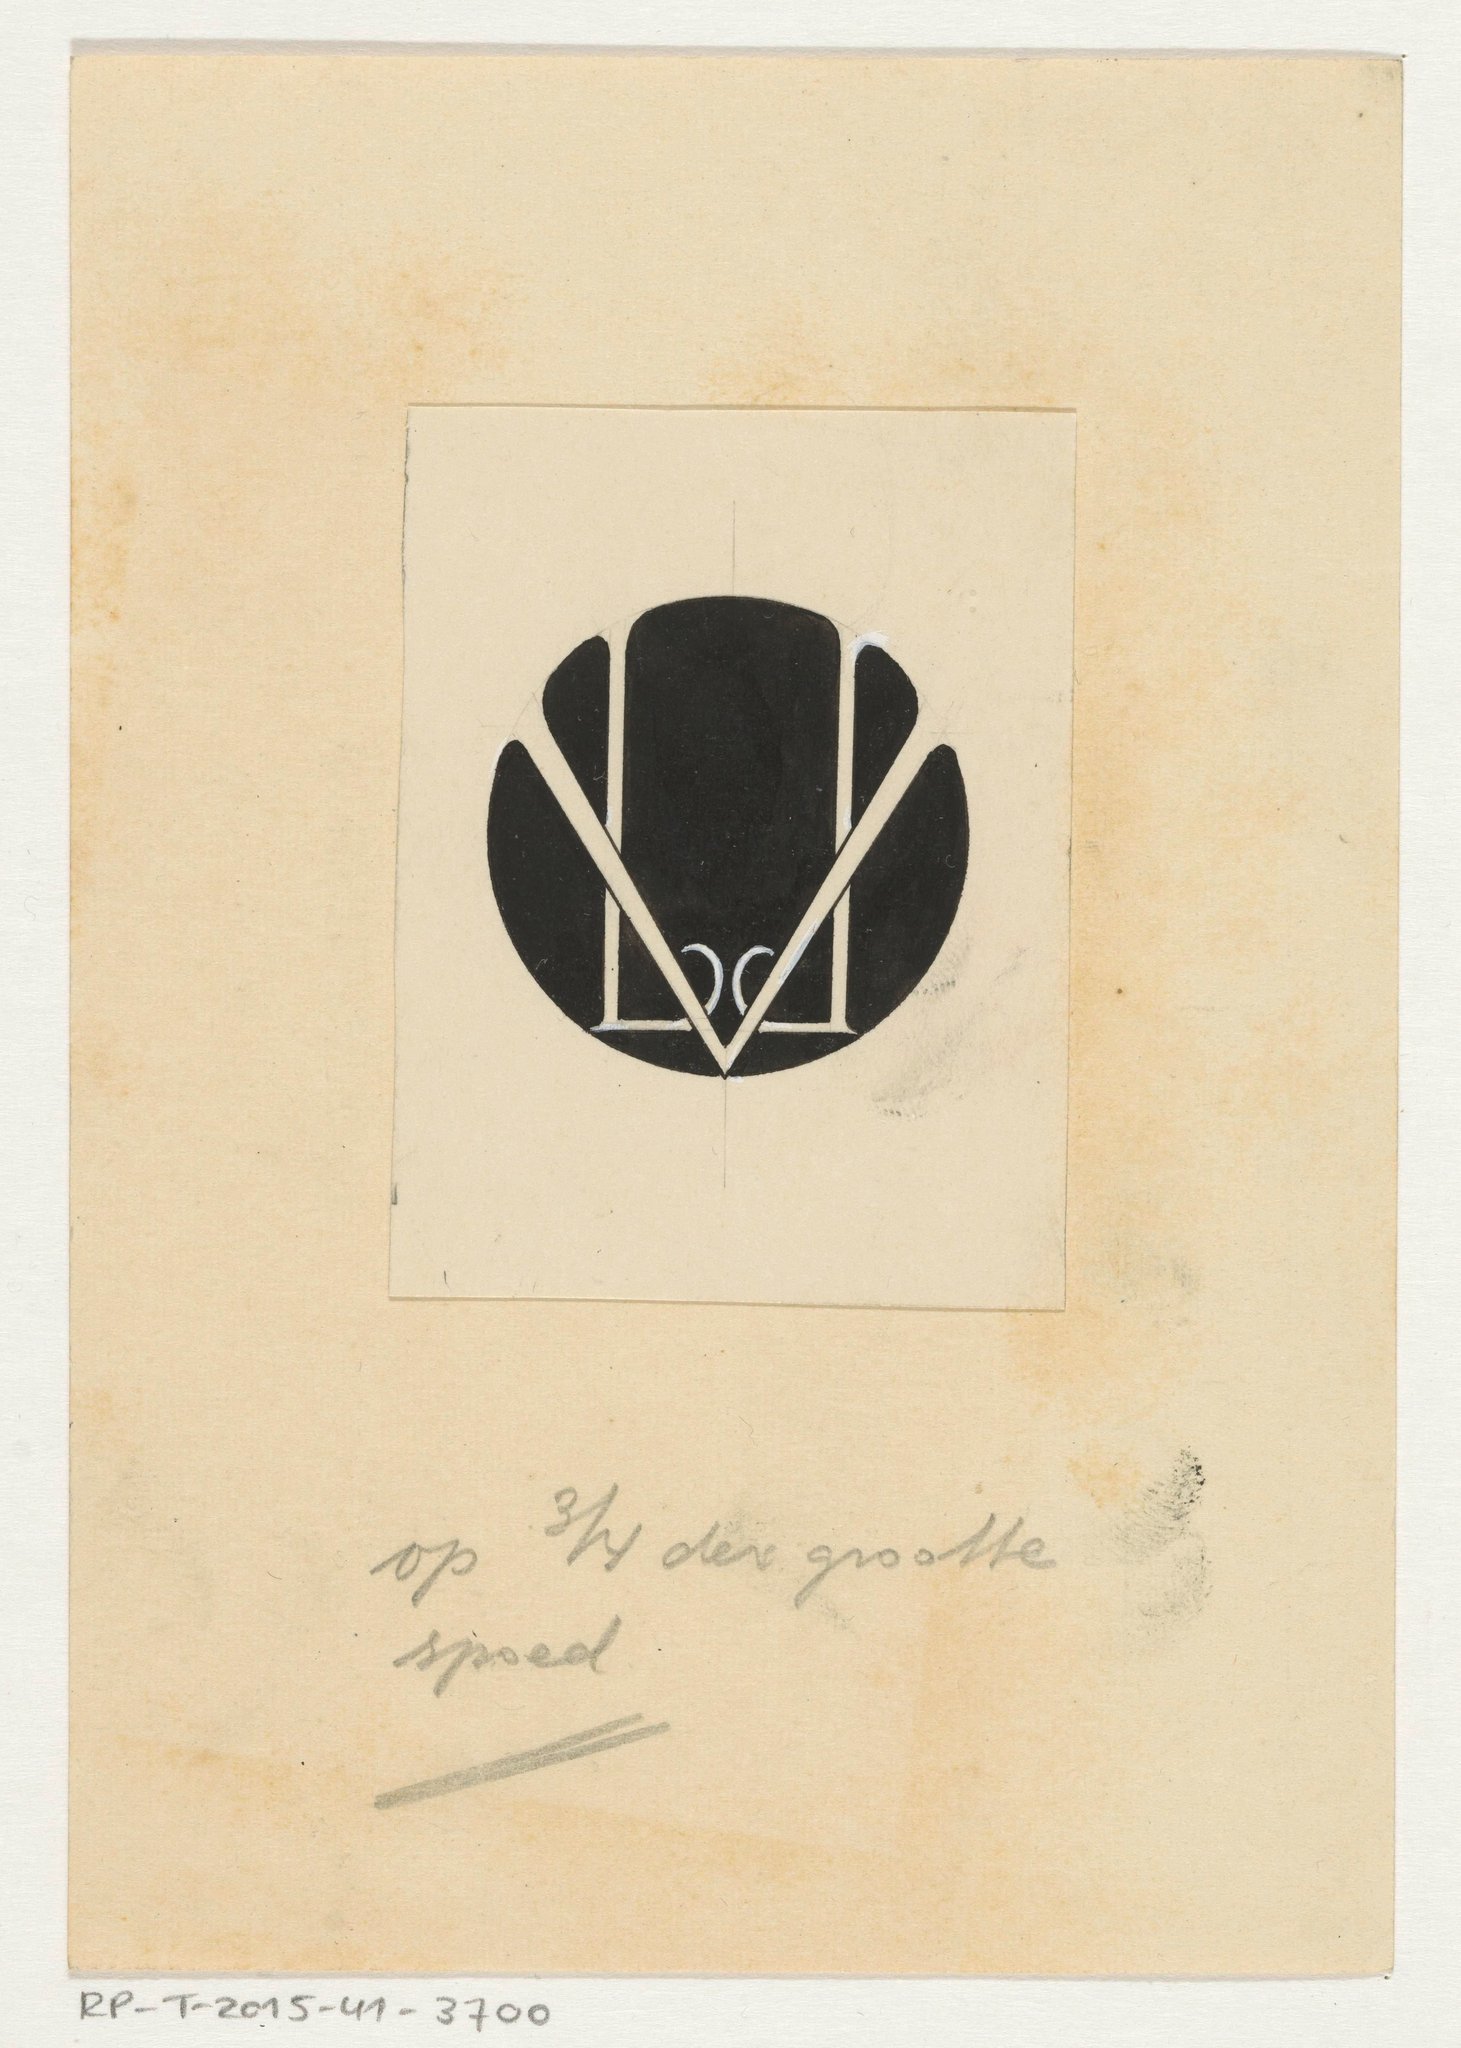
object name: drawing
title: Vignet van Uitgeversmaatschappij L.J. Veen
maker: Anonymous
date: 1887-1930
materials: paint, ink, paper, pencil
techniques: brush, pen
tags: magic mathematical figures; magic numbers, words, monograms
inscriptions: :, collector's mark: Lugt 2228a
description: Cirkel met de vervlochten letters L, J en V.